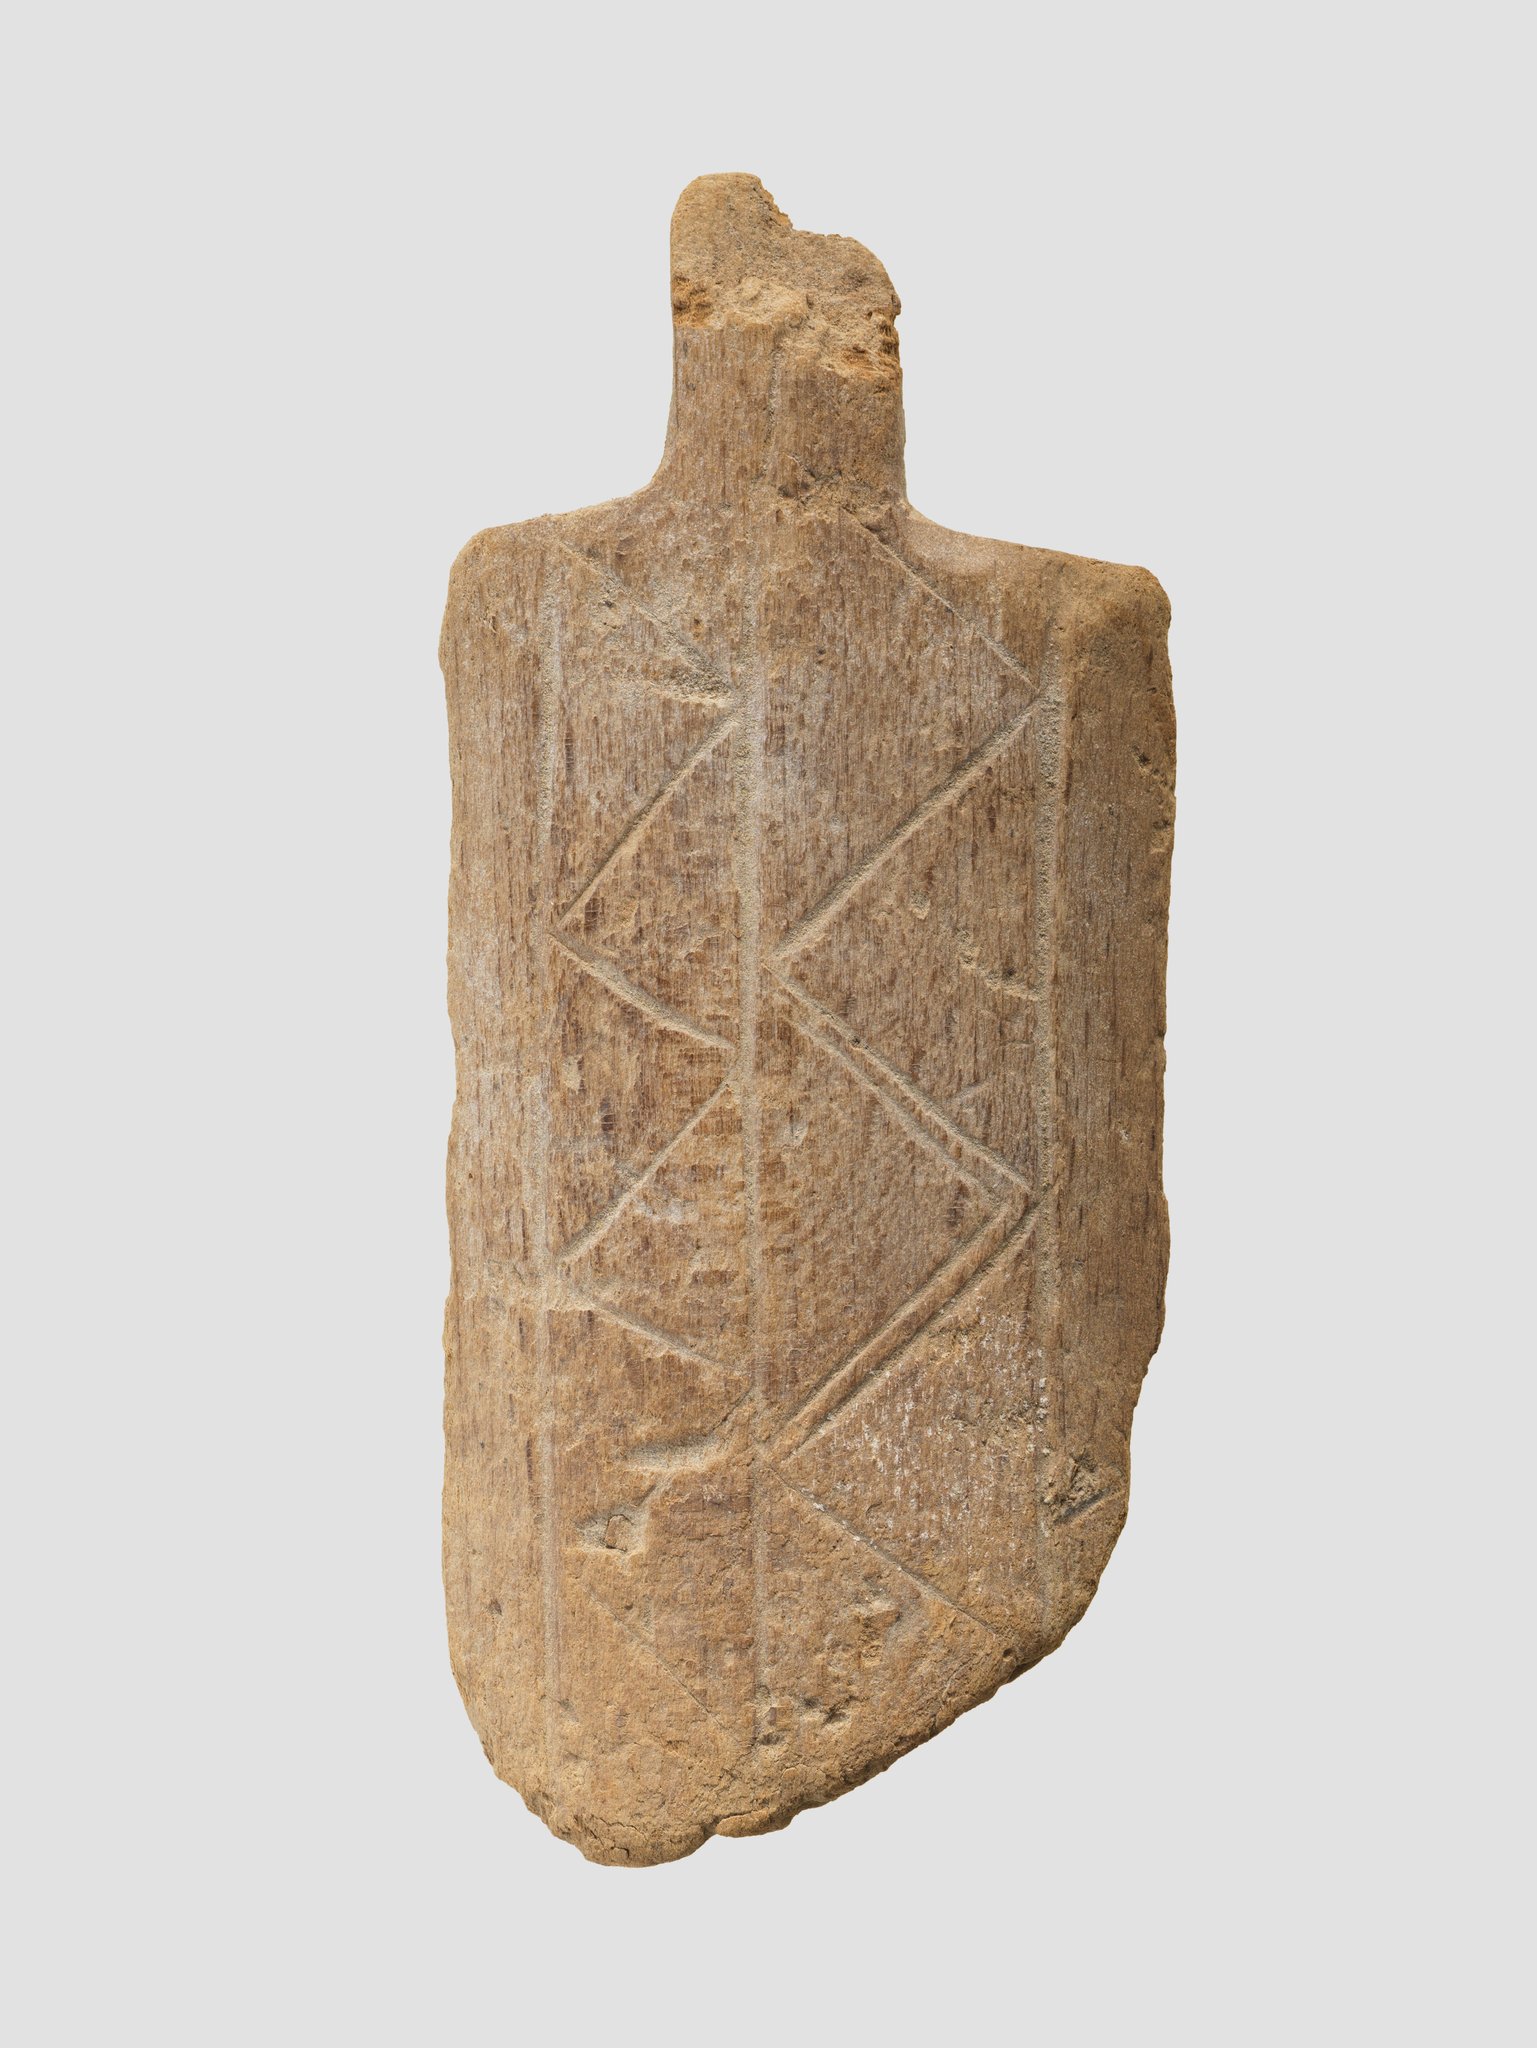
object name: box with lid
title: Wooden box lid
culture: alanic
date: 601-900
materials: wood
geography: caucasus